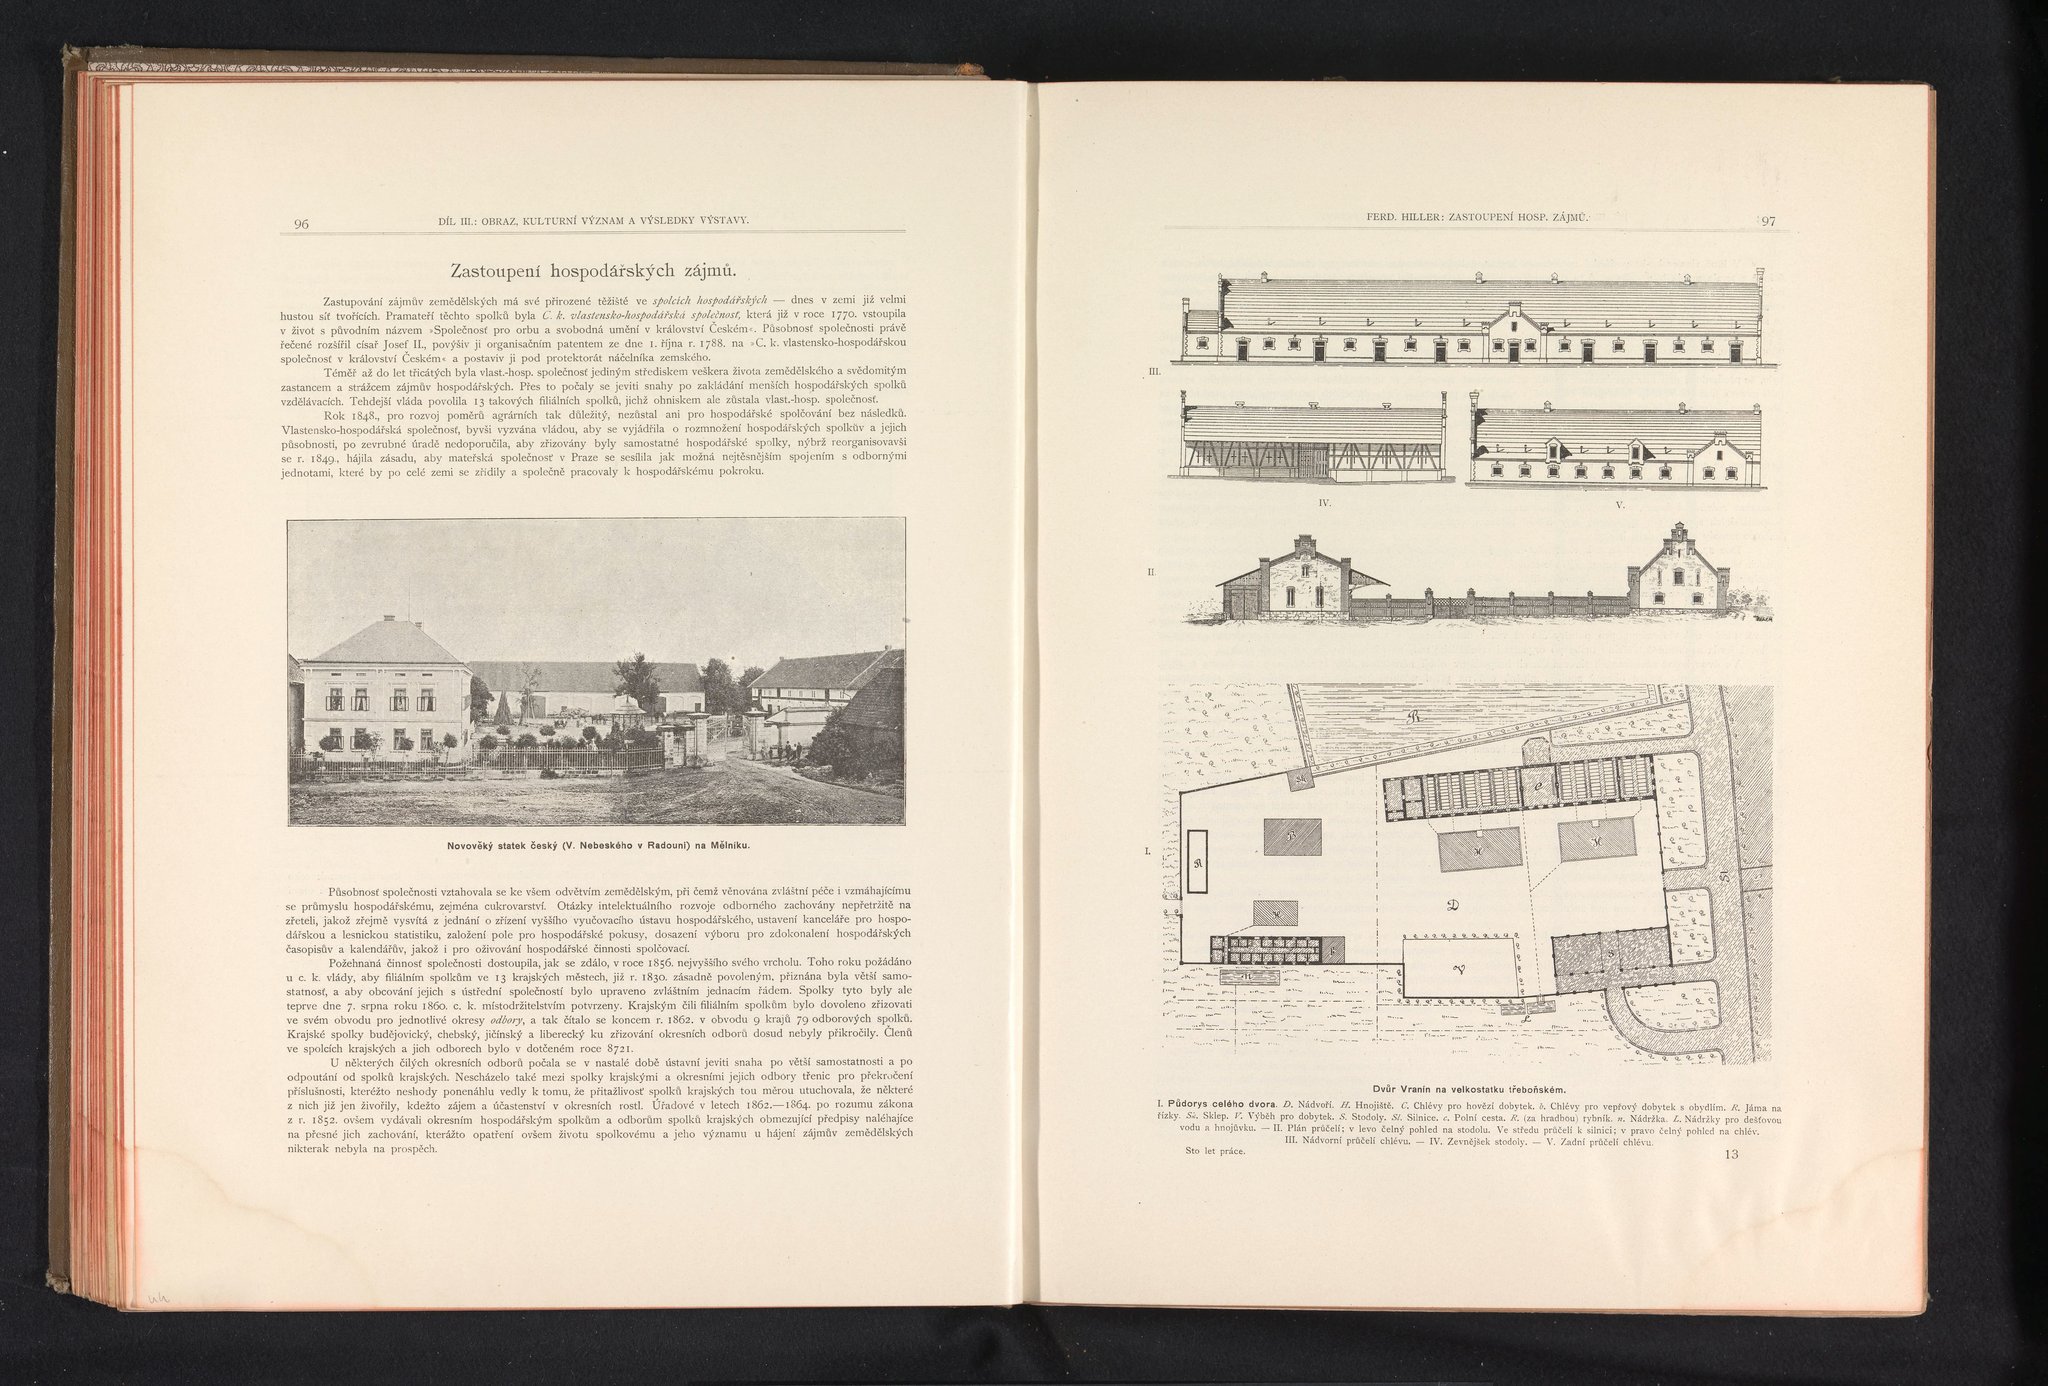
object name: page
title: Novoveky statek ceský (V. Nebeského v Radouni) na Melníku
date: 1891-1895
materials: paper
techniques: autotype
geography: prague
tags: façade (of house or building), farm (building)